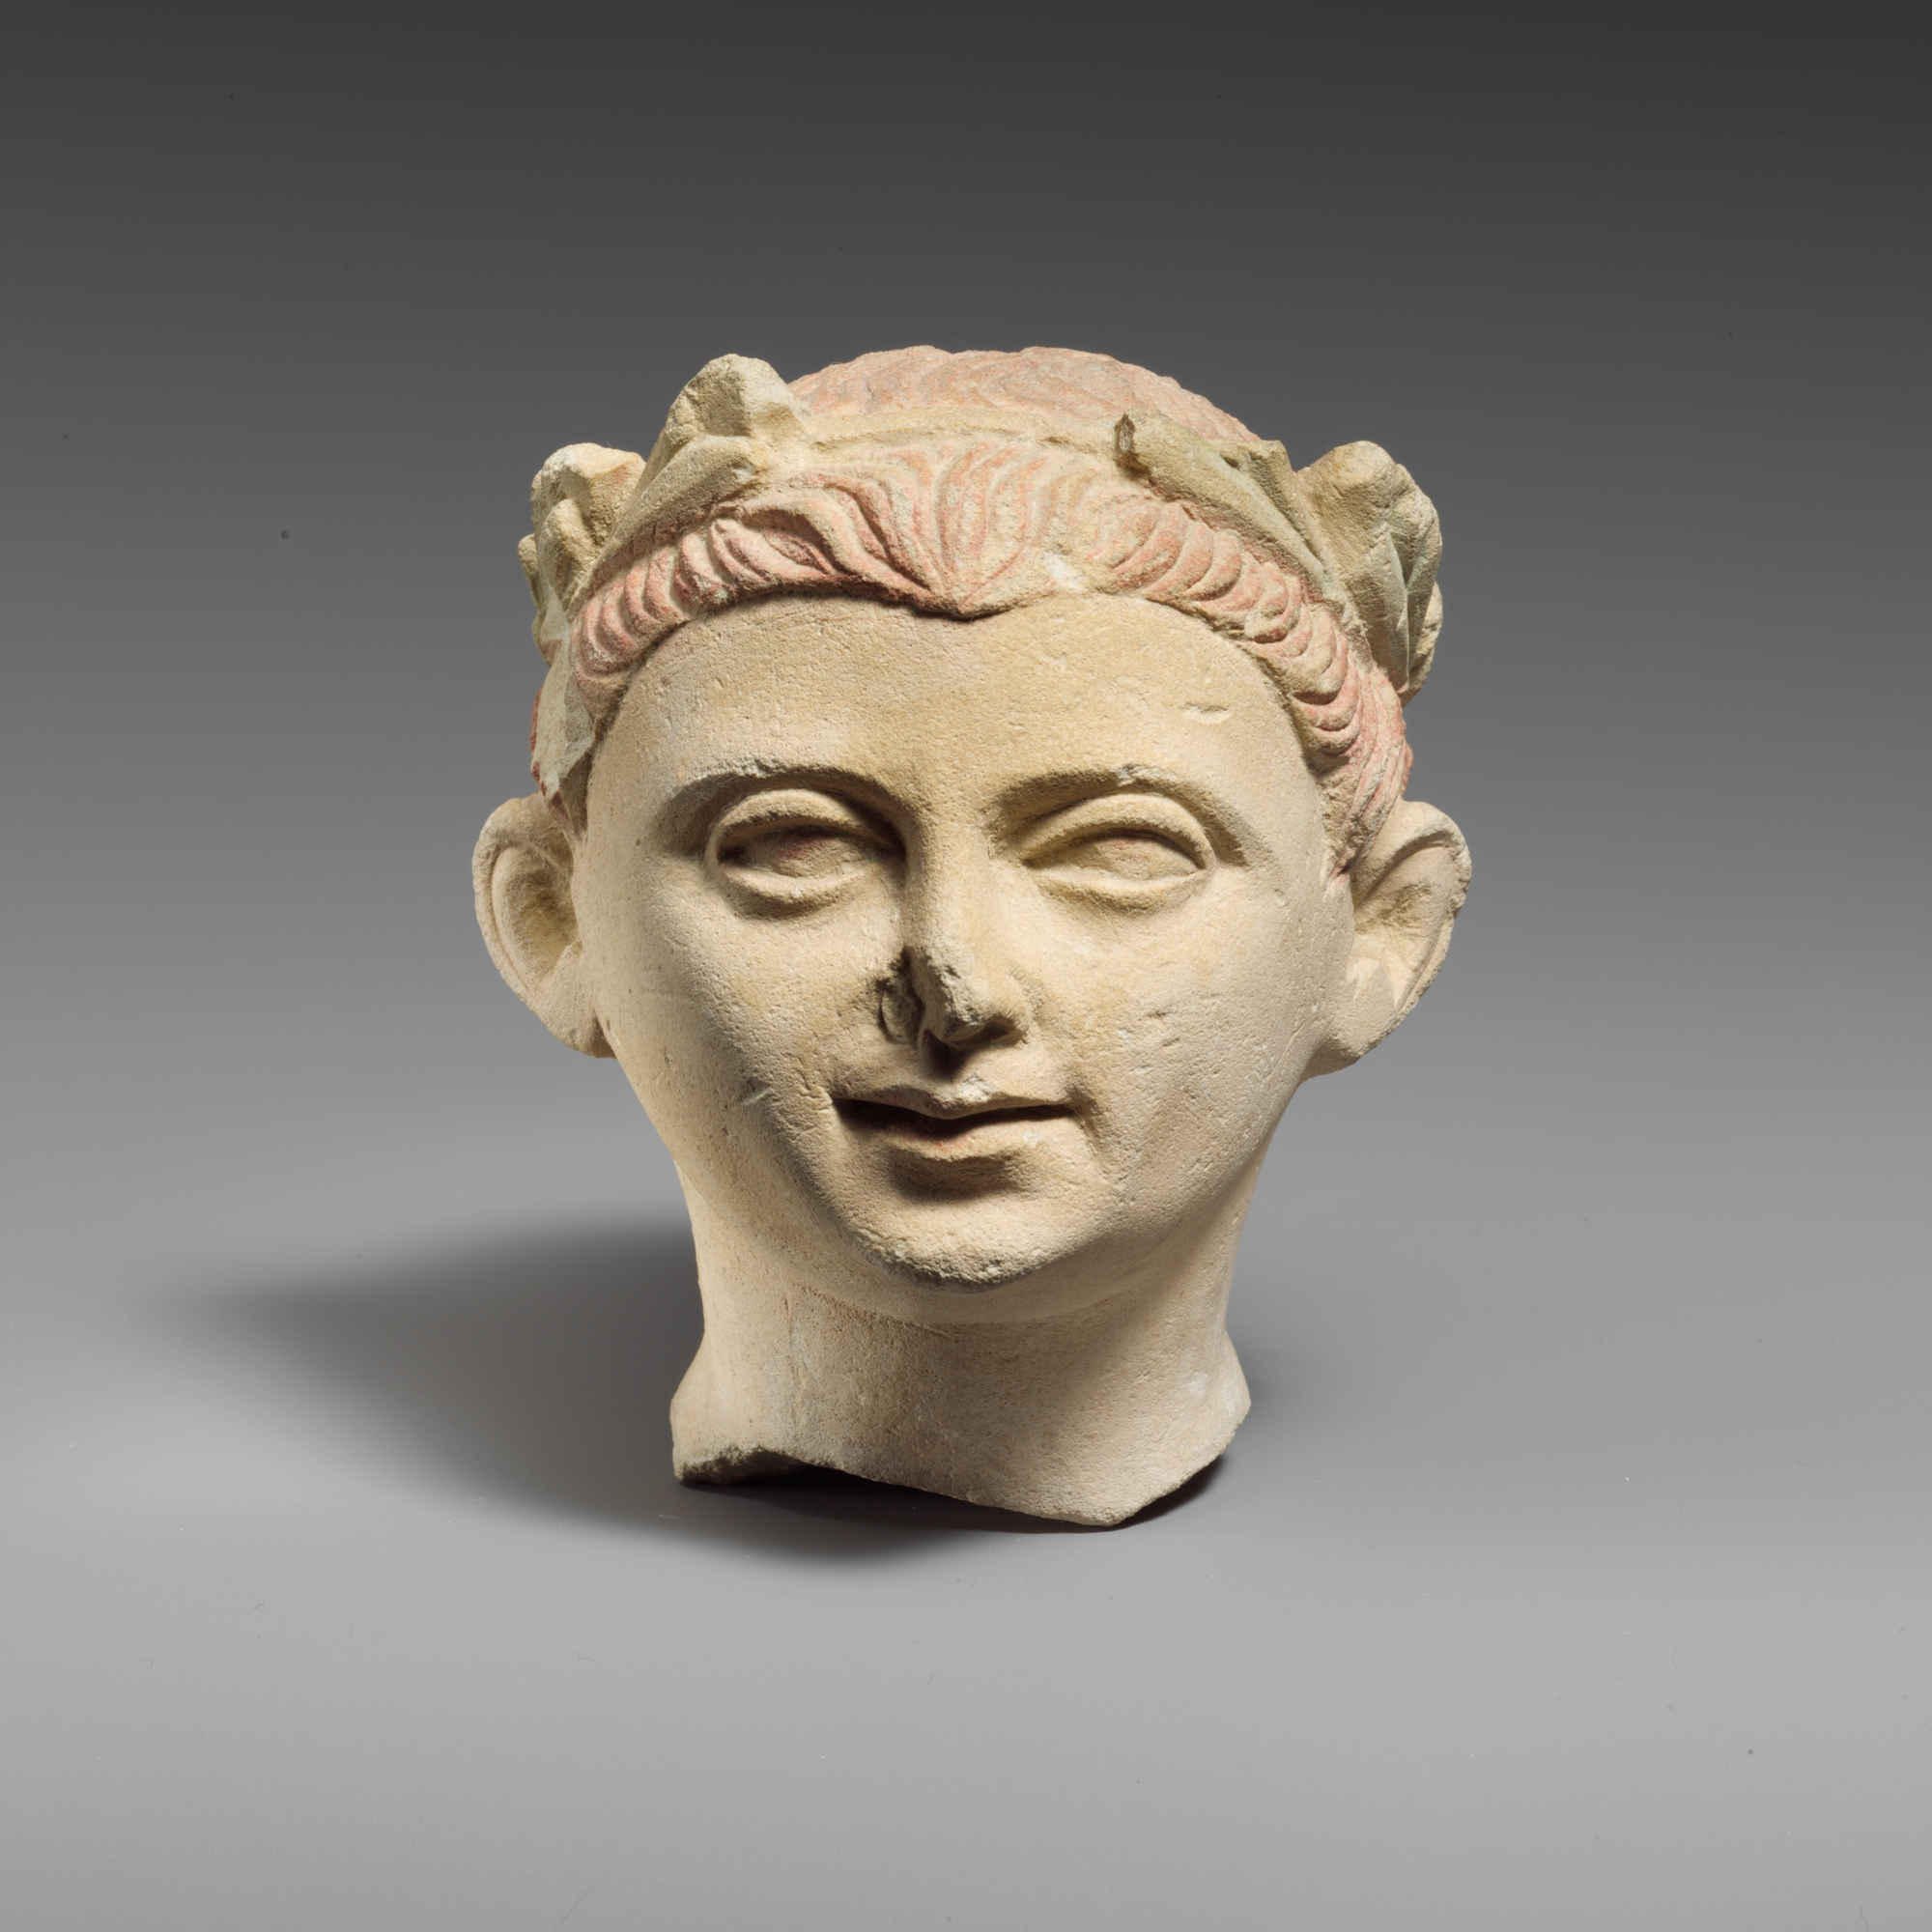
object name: head of a male votary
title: Limestone head of a boy with a wreath of leaves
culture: cypriot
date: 400-301 BCE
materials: limestone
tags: heads,boys,leaves,wreaths